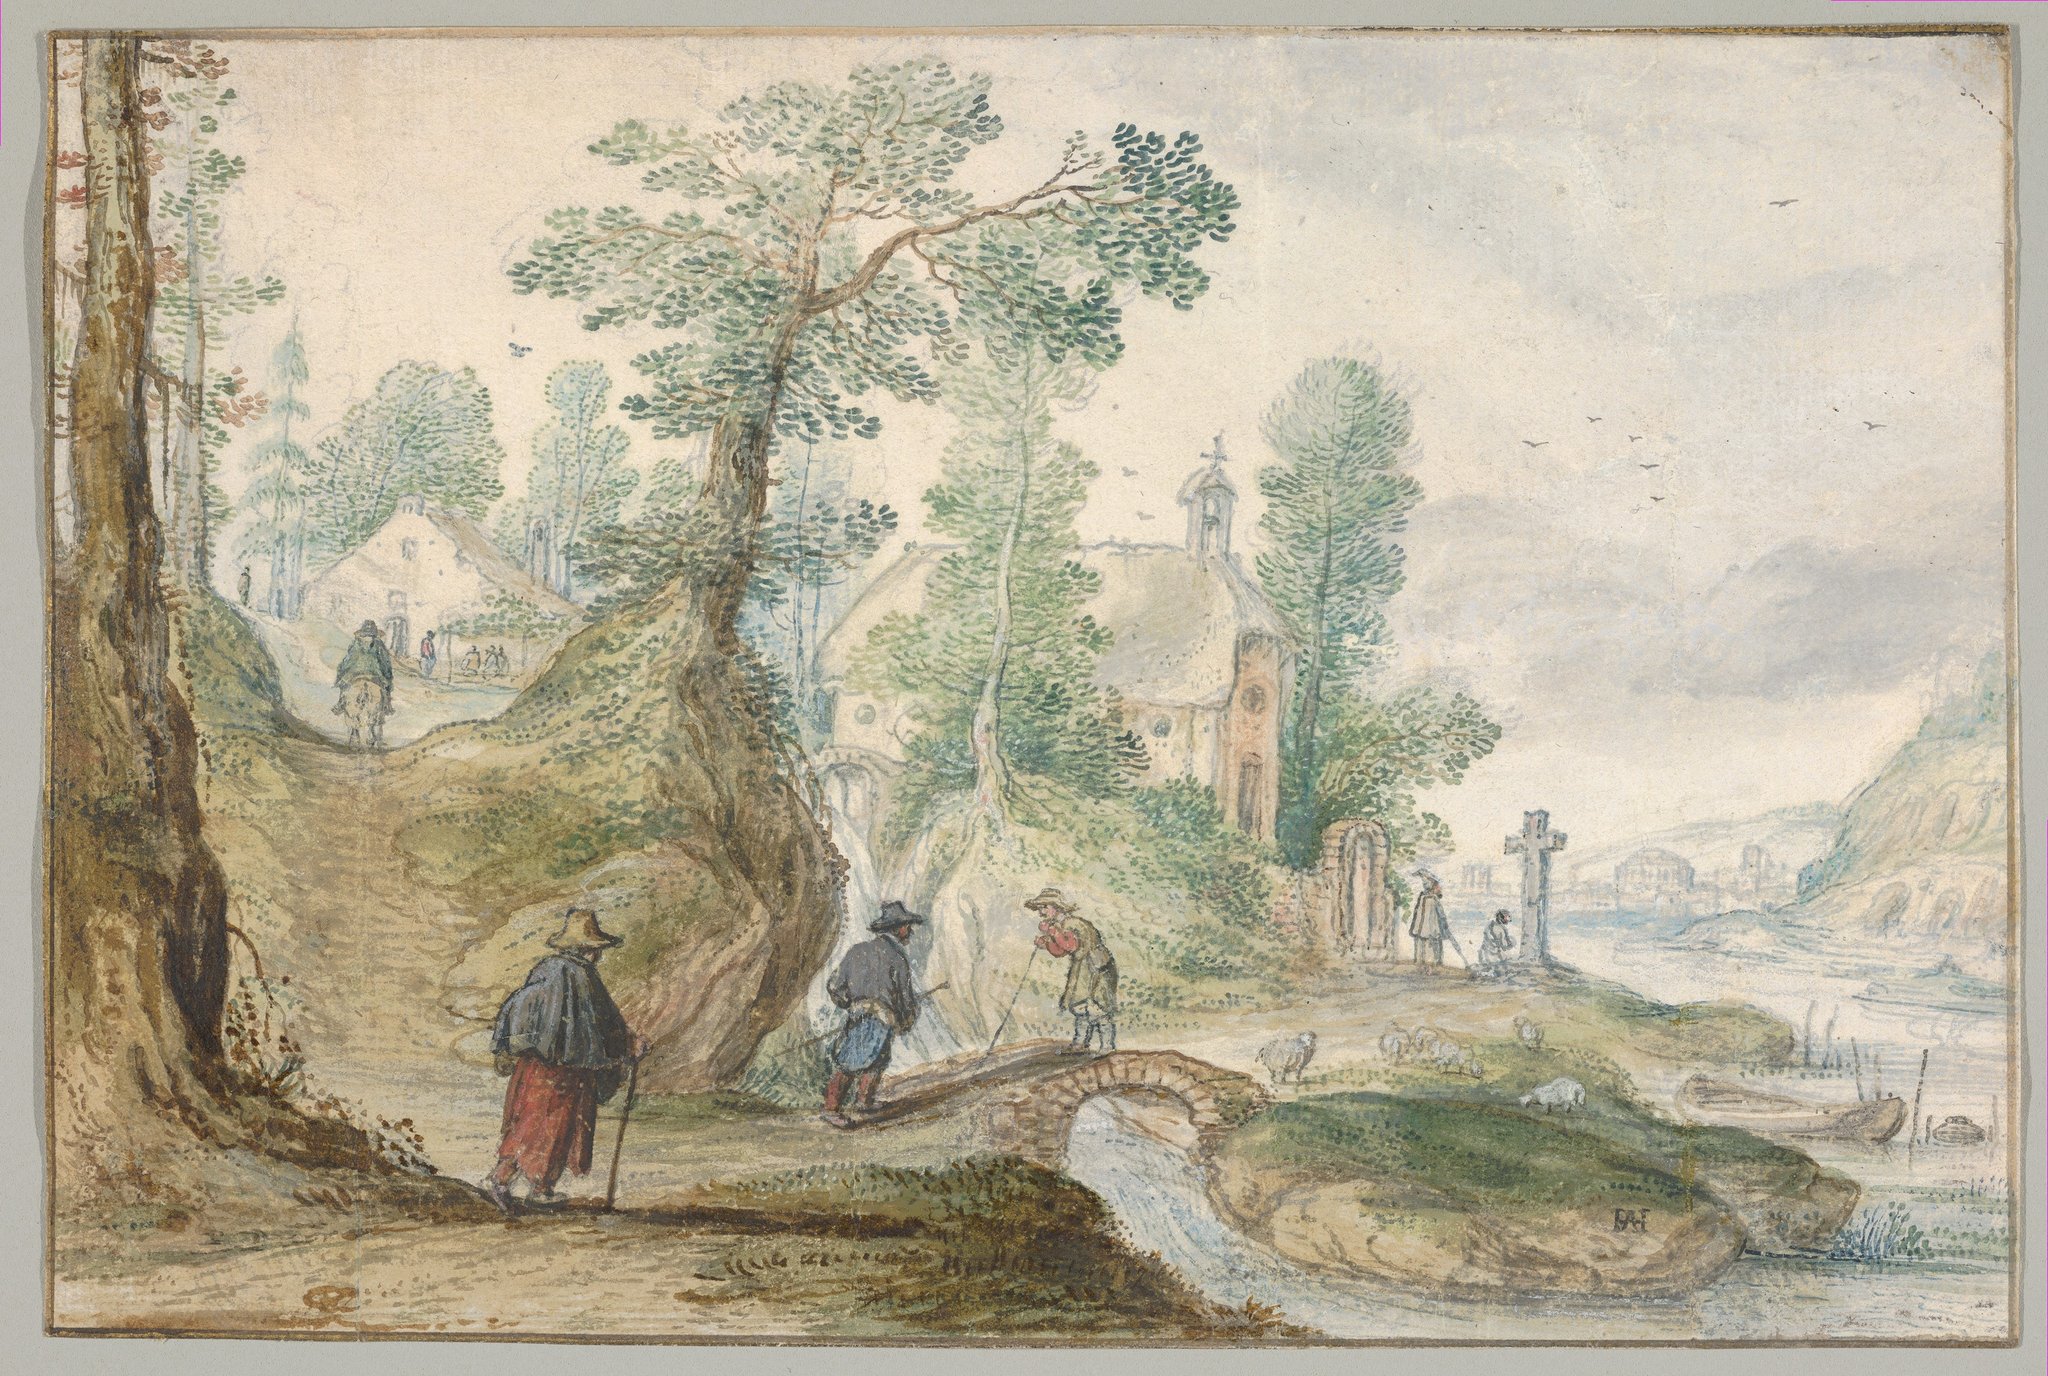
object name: drawing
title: A Wooded River Landscape with a Church and Figures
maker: hendrick avercamp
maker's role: artist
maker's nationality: dutch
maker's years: 1585-1634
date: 1613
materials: gold paint, gouache, graphite, ink, lead, paper, watercolor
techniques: pen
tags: churches,rivers,landscapes